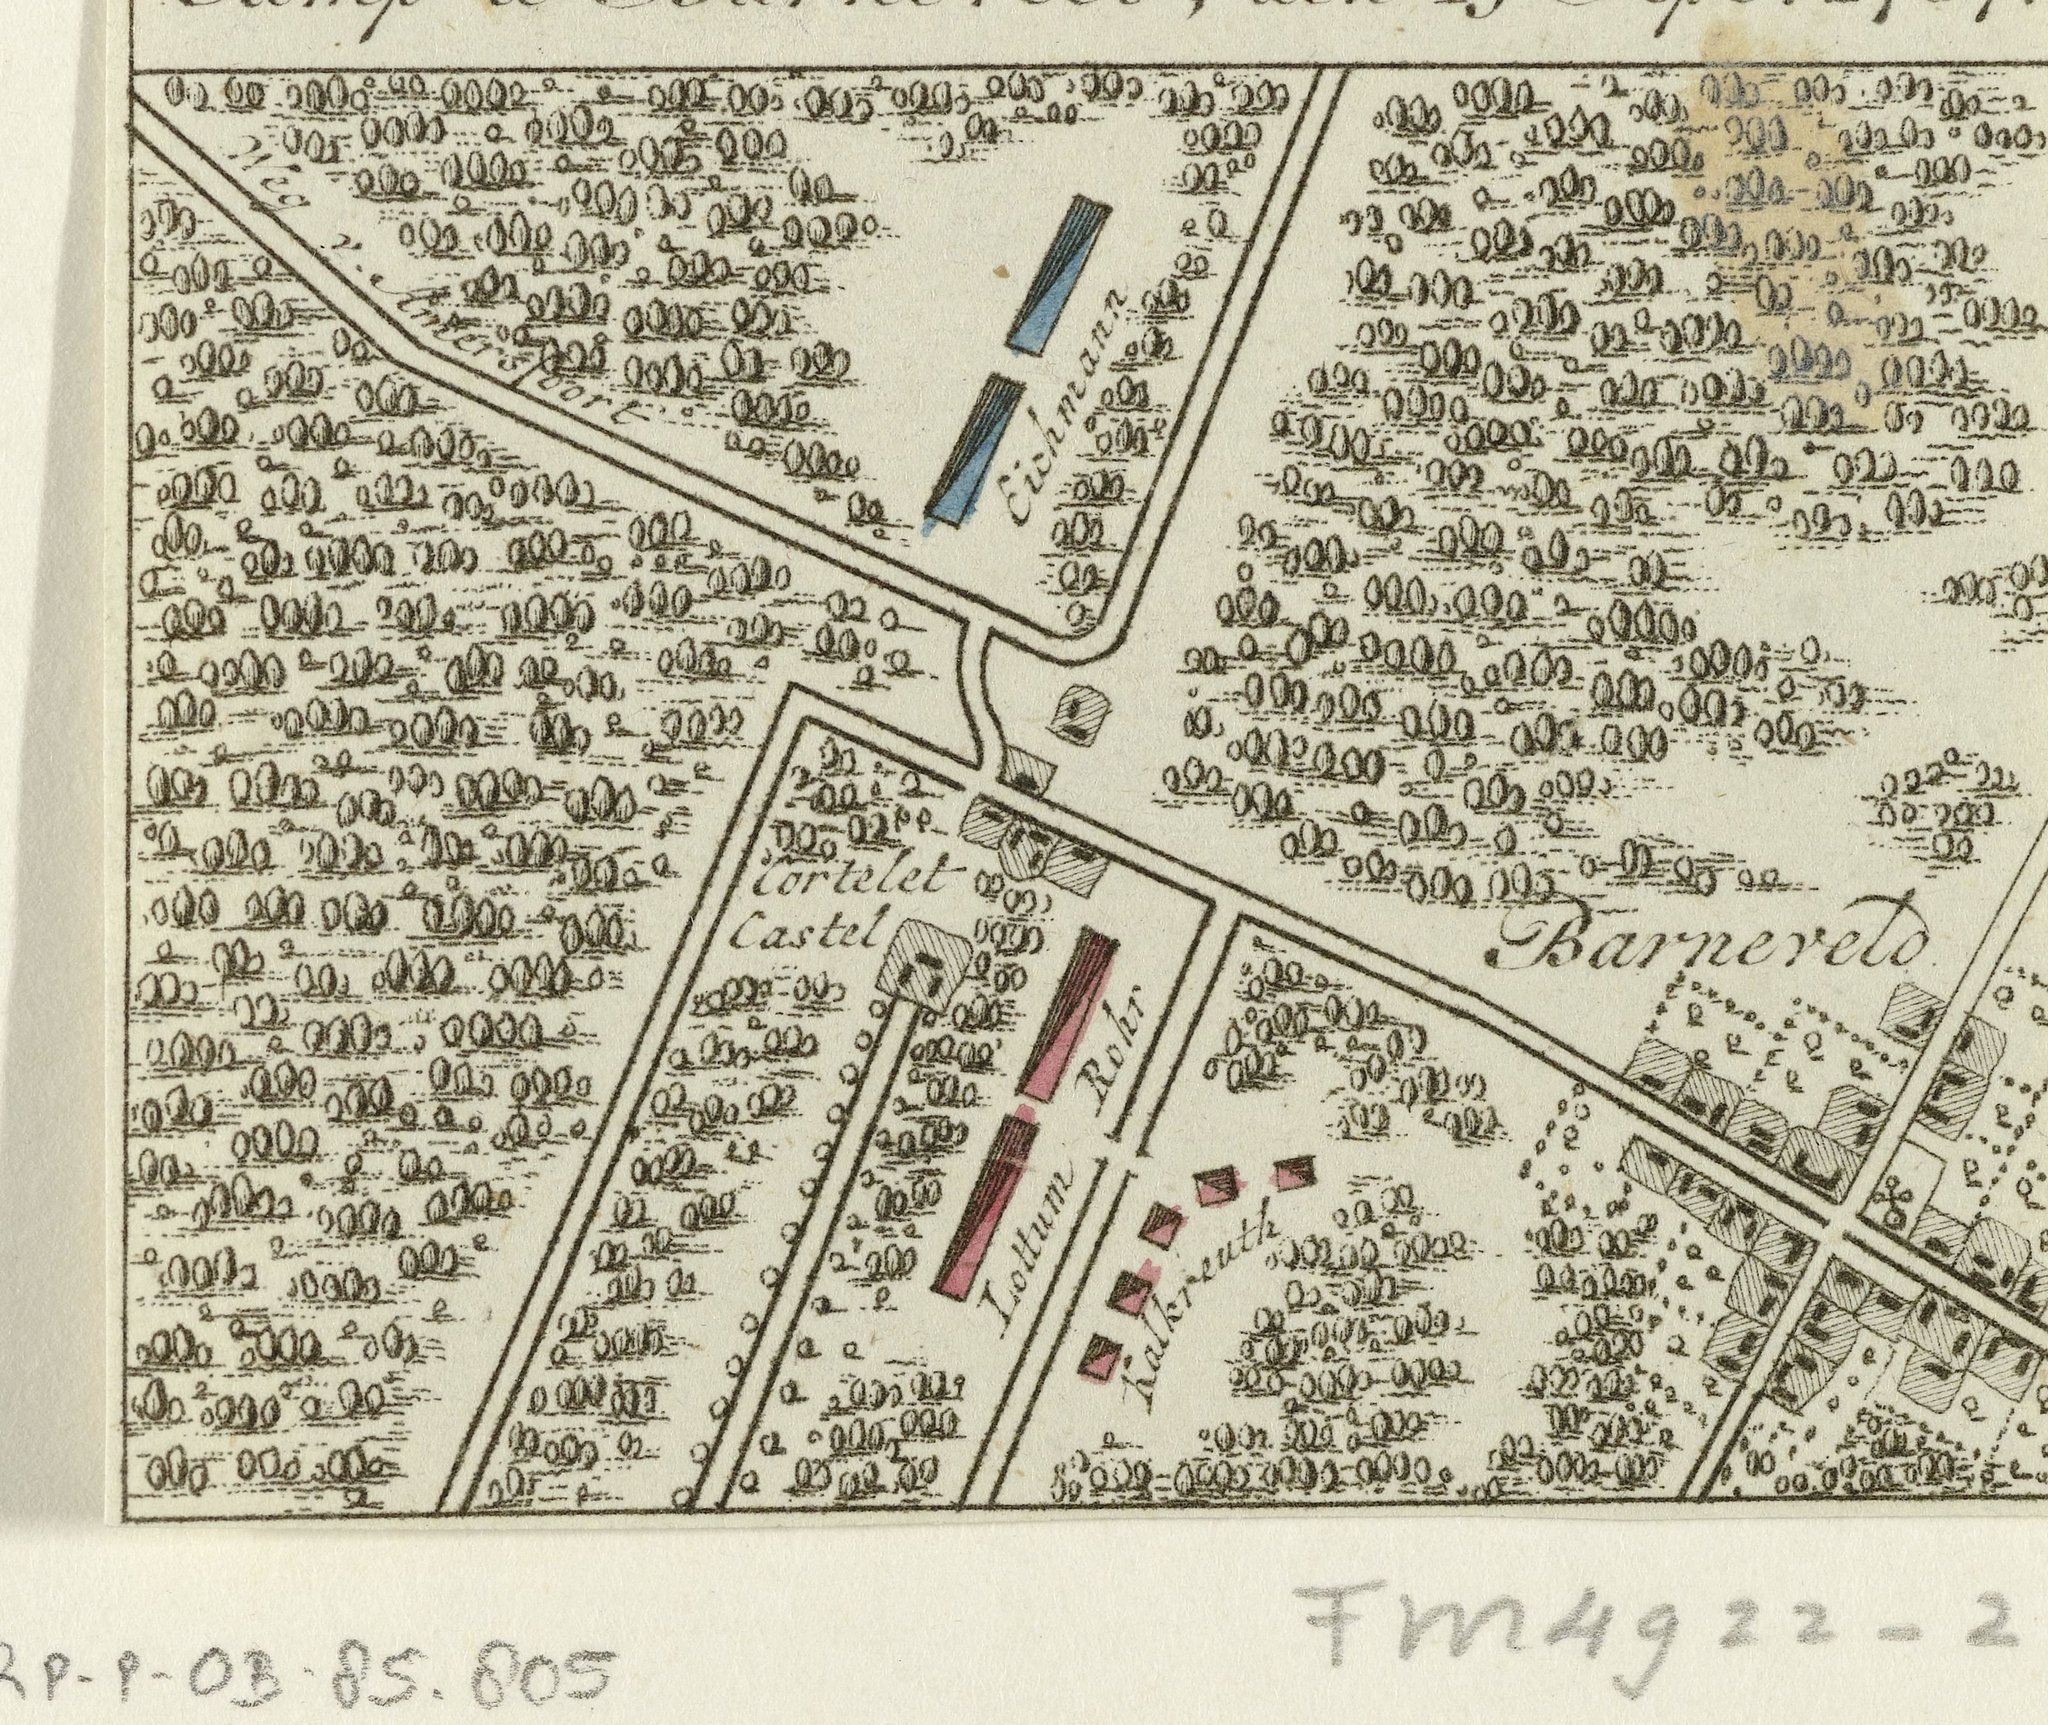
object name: map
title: Kampement van de Pruisen te Barneveld, 1787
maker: Anonymous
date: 1790-1792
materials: paper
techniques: etching, hand coloring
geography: northern netherlands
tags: maps of cities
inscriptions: collector's mark: Lugt 2228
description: Kaart met de ligging van het kampement van de Pruisische troepen bij Barneveld op 15 september 1787. Onderdeel van een groep van veertien genummerde kaartjes van de kampementen van de Pruisische troepen tijdens de interventie in de Nederlanden in september 1787.